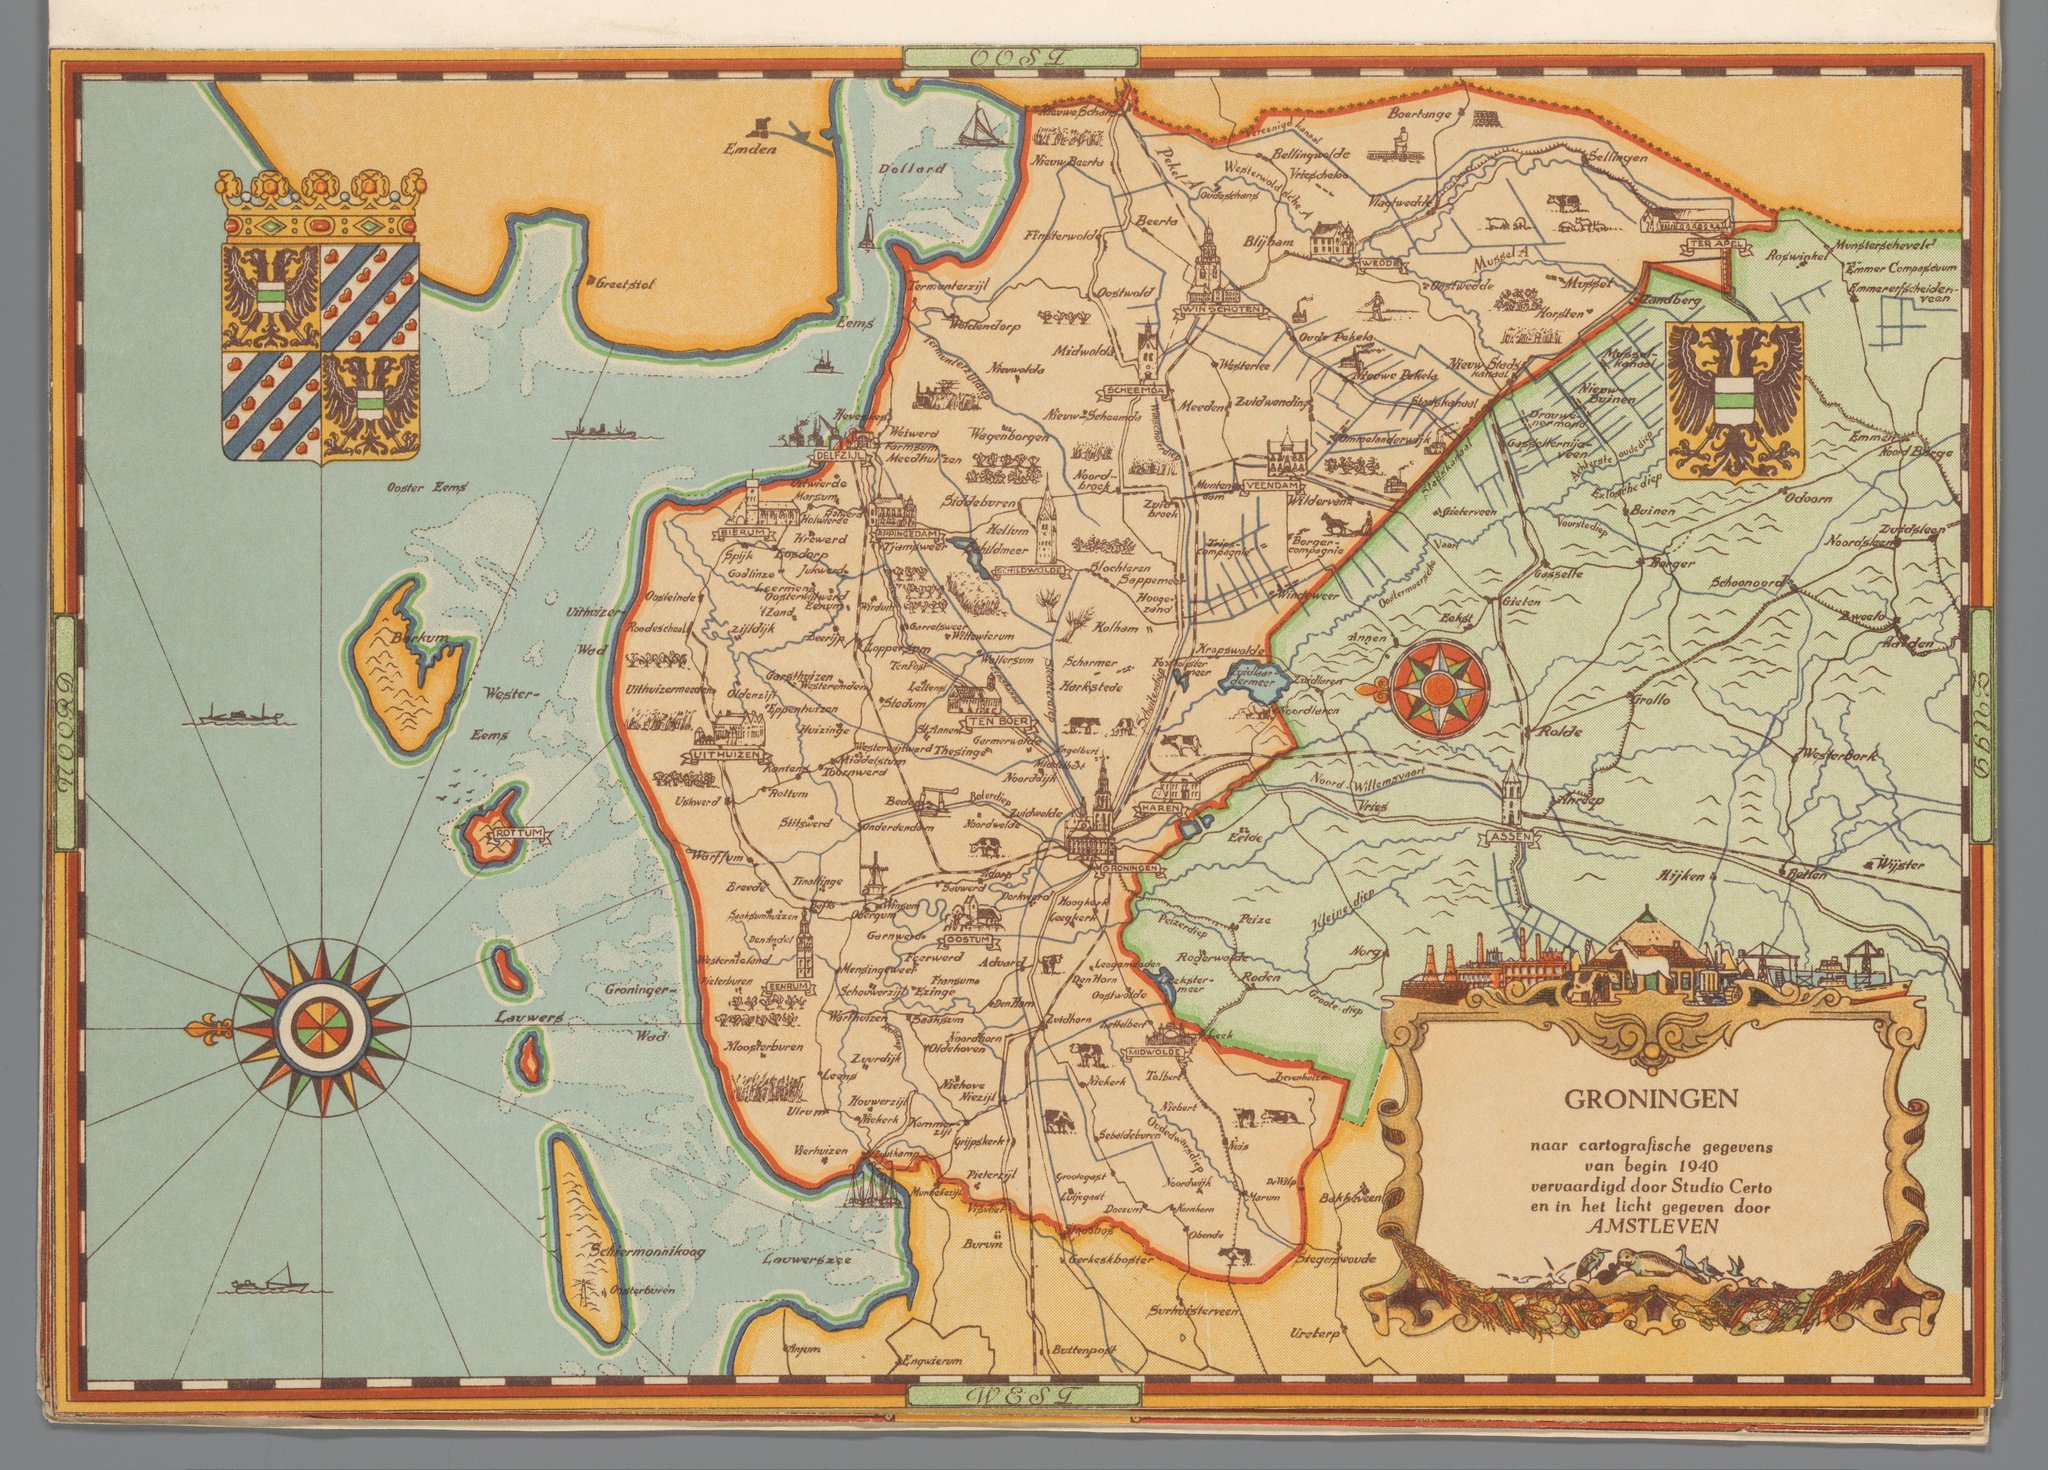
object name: print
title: Groningen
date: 1947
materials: paper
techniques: lithograph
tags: maps, atlases, groningen (province)